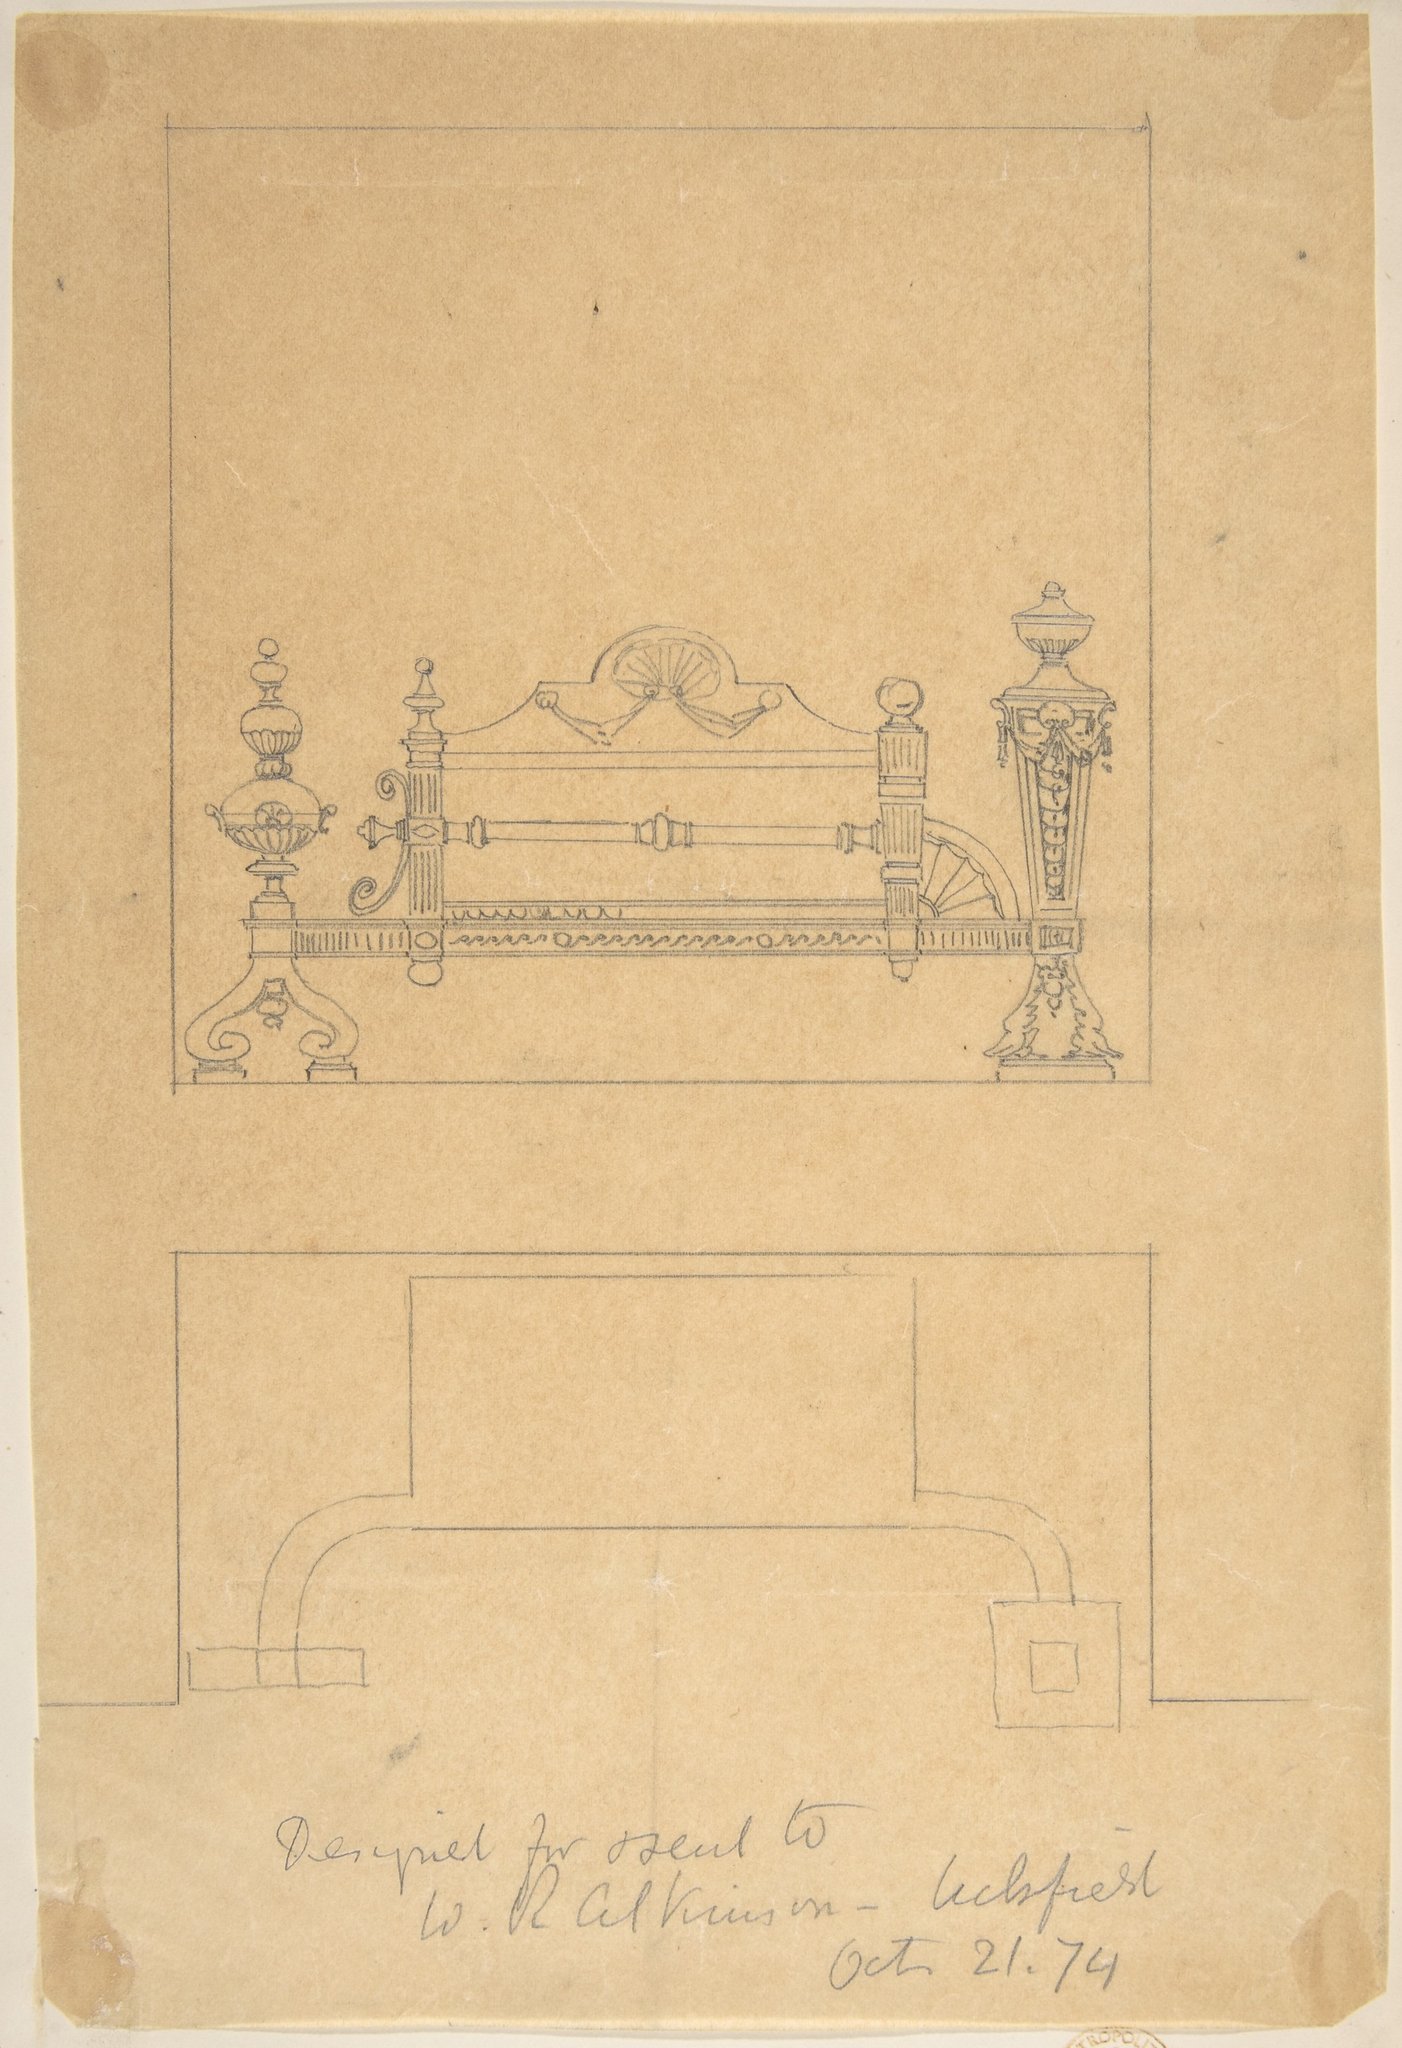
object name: drawing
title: Design for Grate, with Plan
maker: anonymous, british, 19th century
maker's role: artist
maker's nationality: british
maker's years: 1800-1900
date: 1874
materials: graphite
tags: architecture